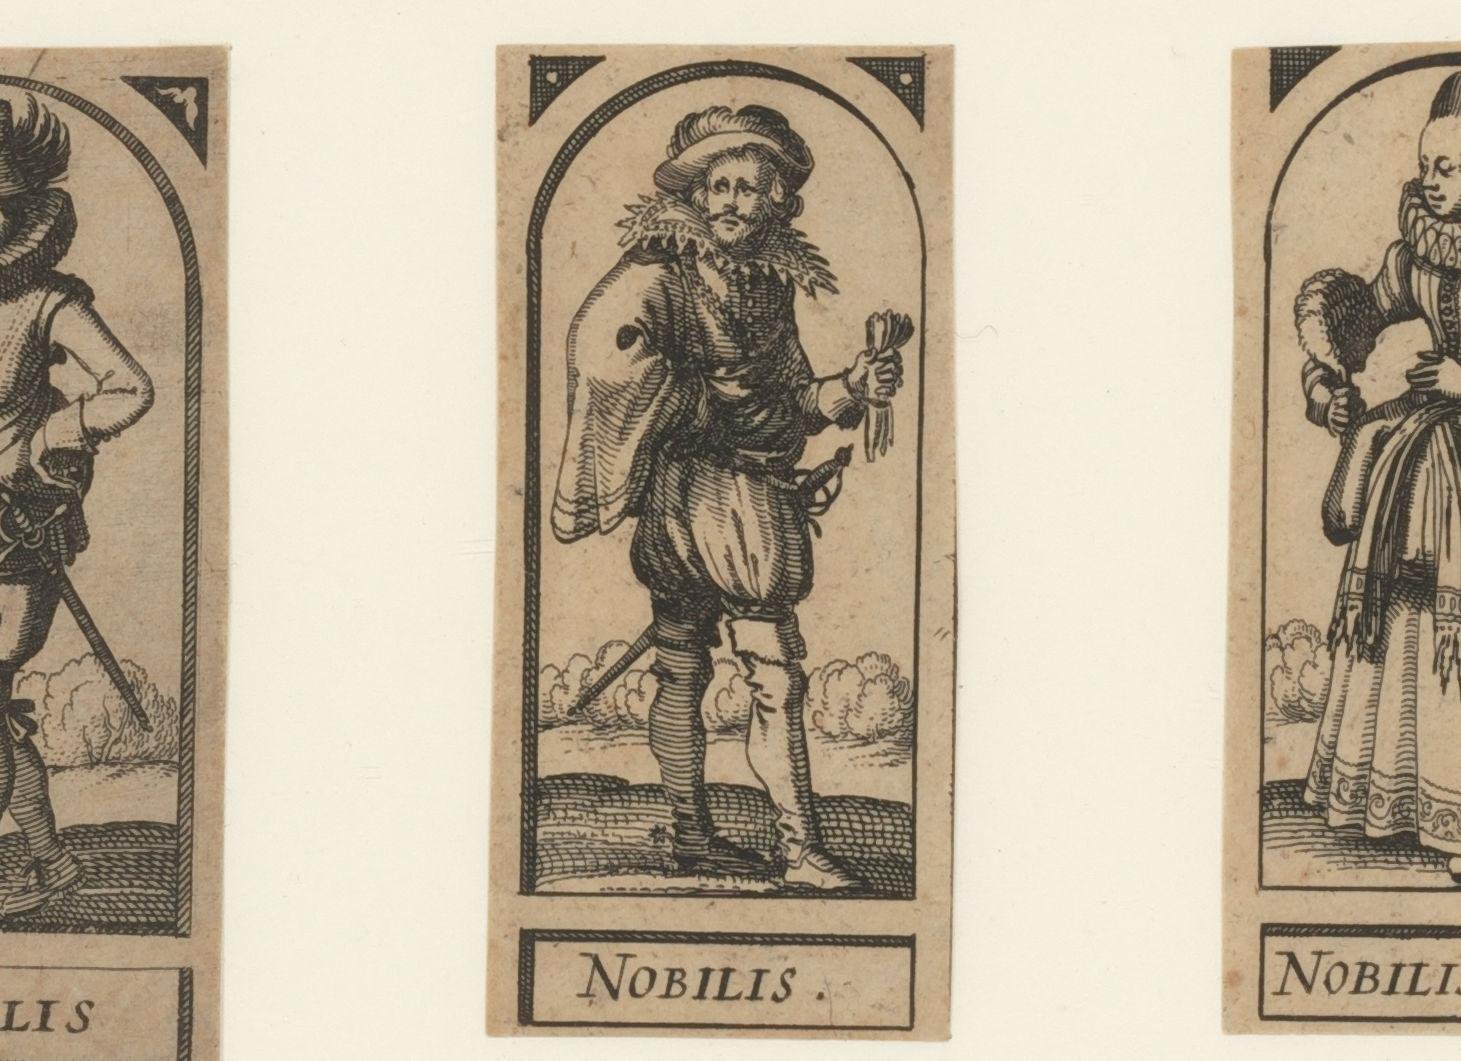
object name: print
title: Kaart van Vlaanderen en Zeeland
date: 1621-1633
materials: paper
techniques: etching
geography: amsterdam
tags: folk costume, regional costume, nobility and patriciate; chivalry, knighthood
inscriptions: stamp, collector's mark: Lugt 1641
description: Onderwerpsrubrieken binnen de Atlas Zeden en Gewoonten: Zeden en Gewoonten in Engeren Zin, De Kleeding, Kleederdrachten (tijdvakken), De Spaansche tijd. (1550 – 1600).